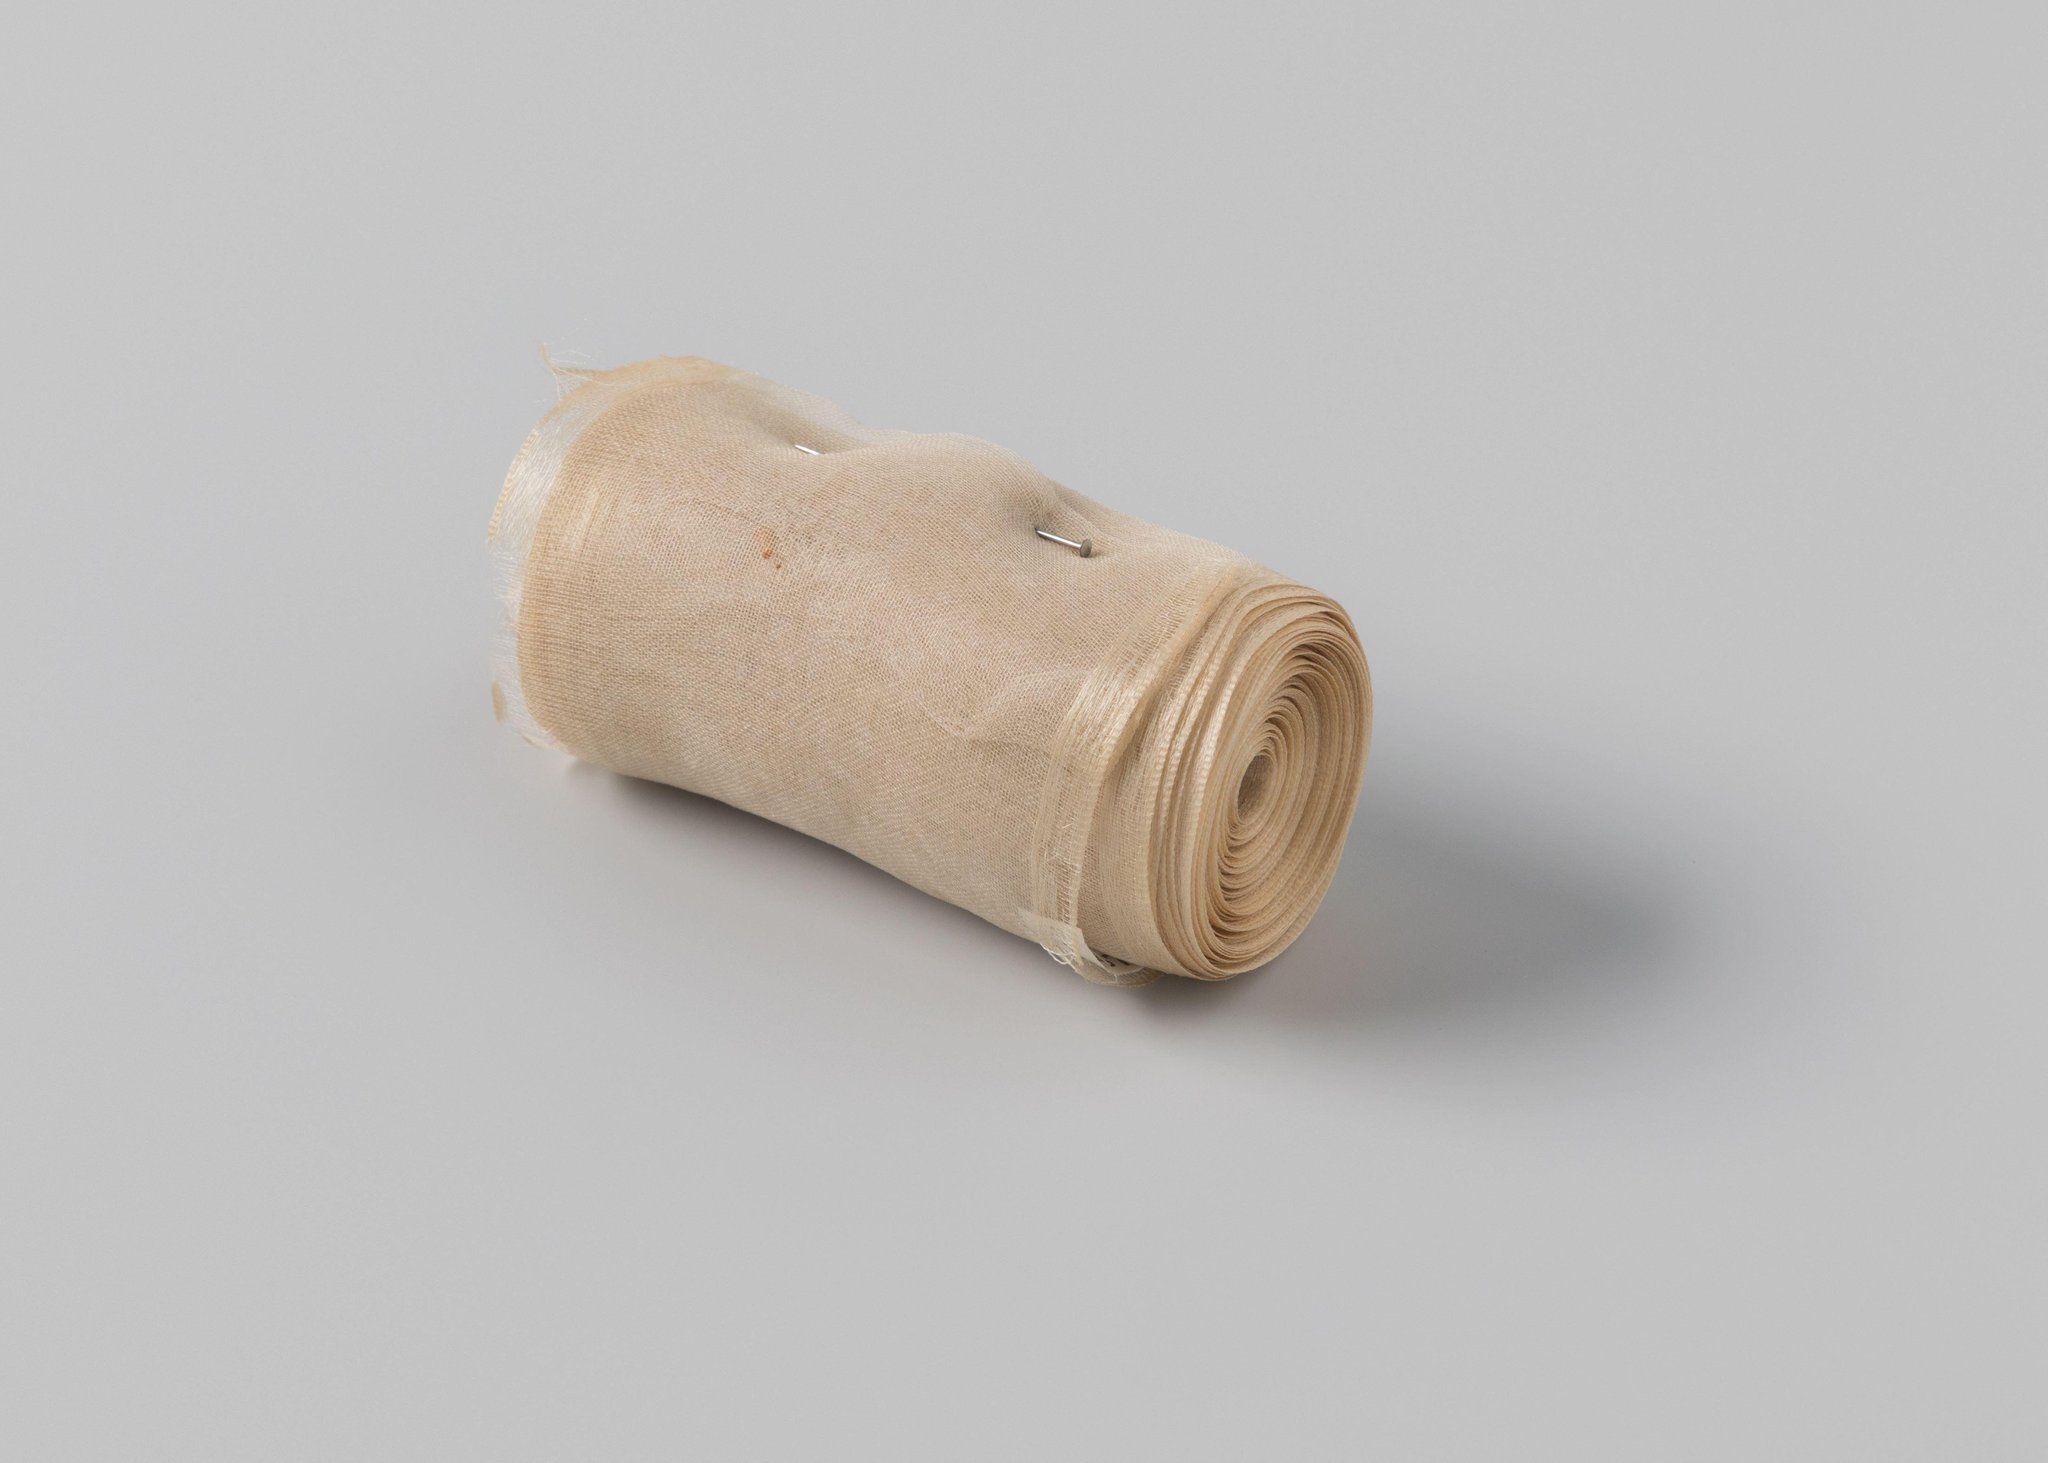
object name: ribbon material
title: Lint van crèmekleurig gaas van 15 meter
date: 1900-1915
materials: textile, silk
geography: france